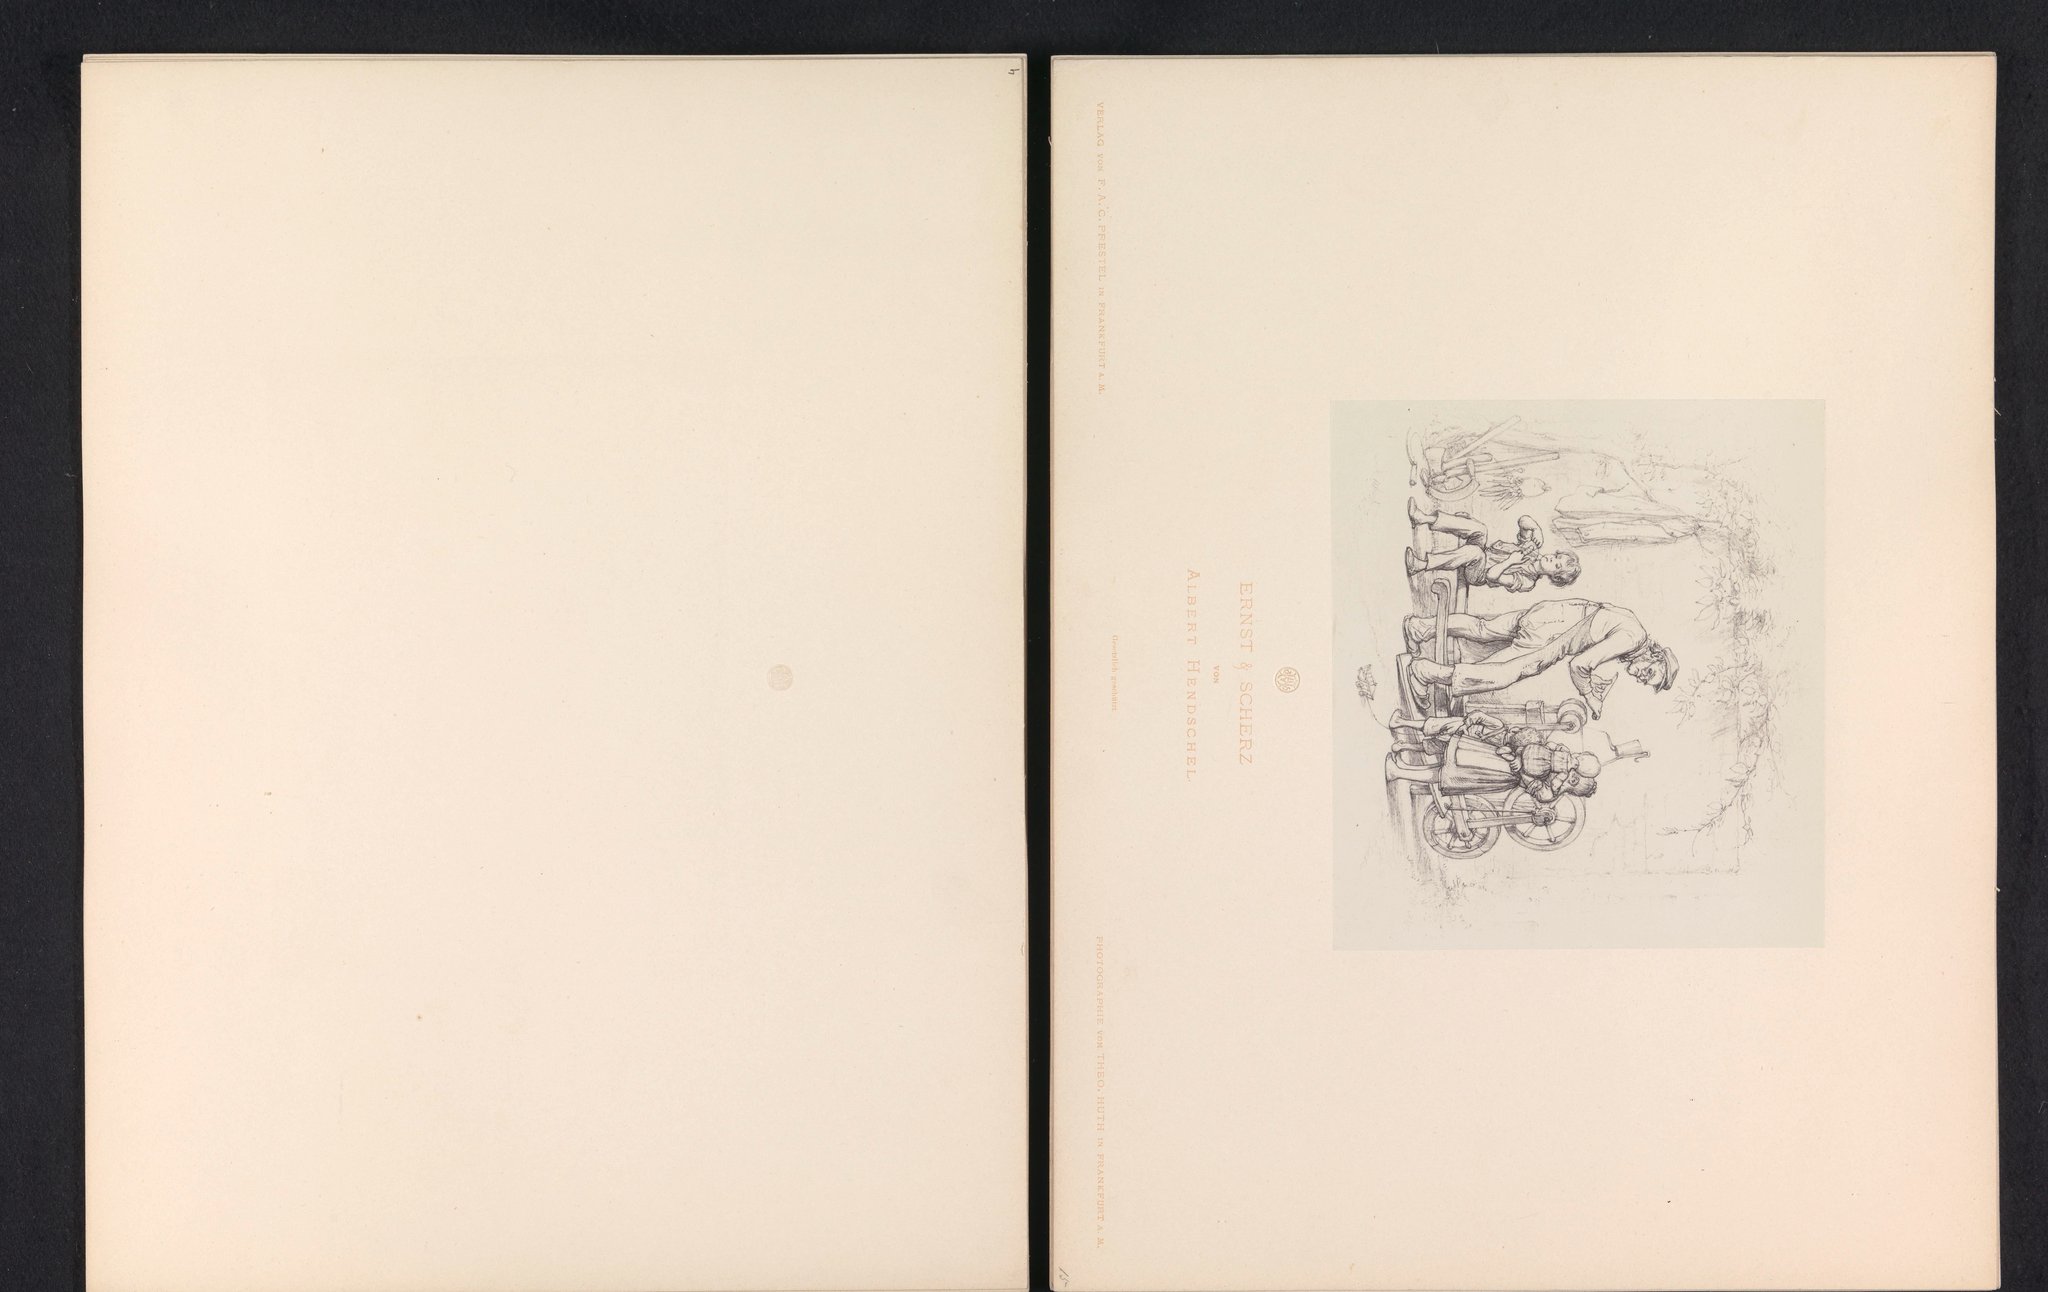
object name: photomechanical print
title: Ernst & Scherz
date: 1869-1879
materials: paper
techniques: woodburytype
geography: frankfurt am main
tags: sharpening, grinding (industrial processes), child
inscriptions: initials: ‘[...]’